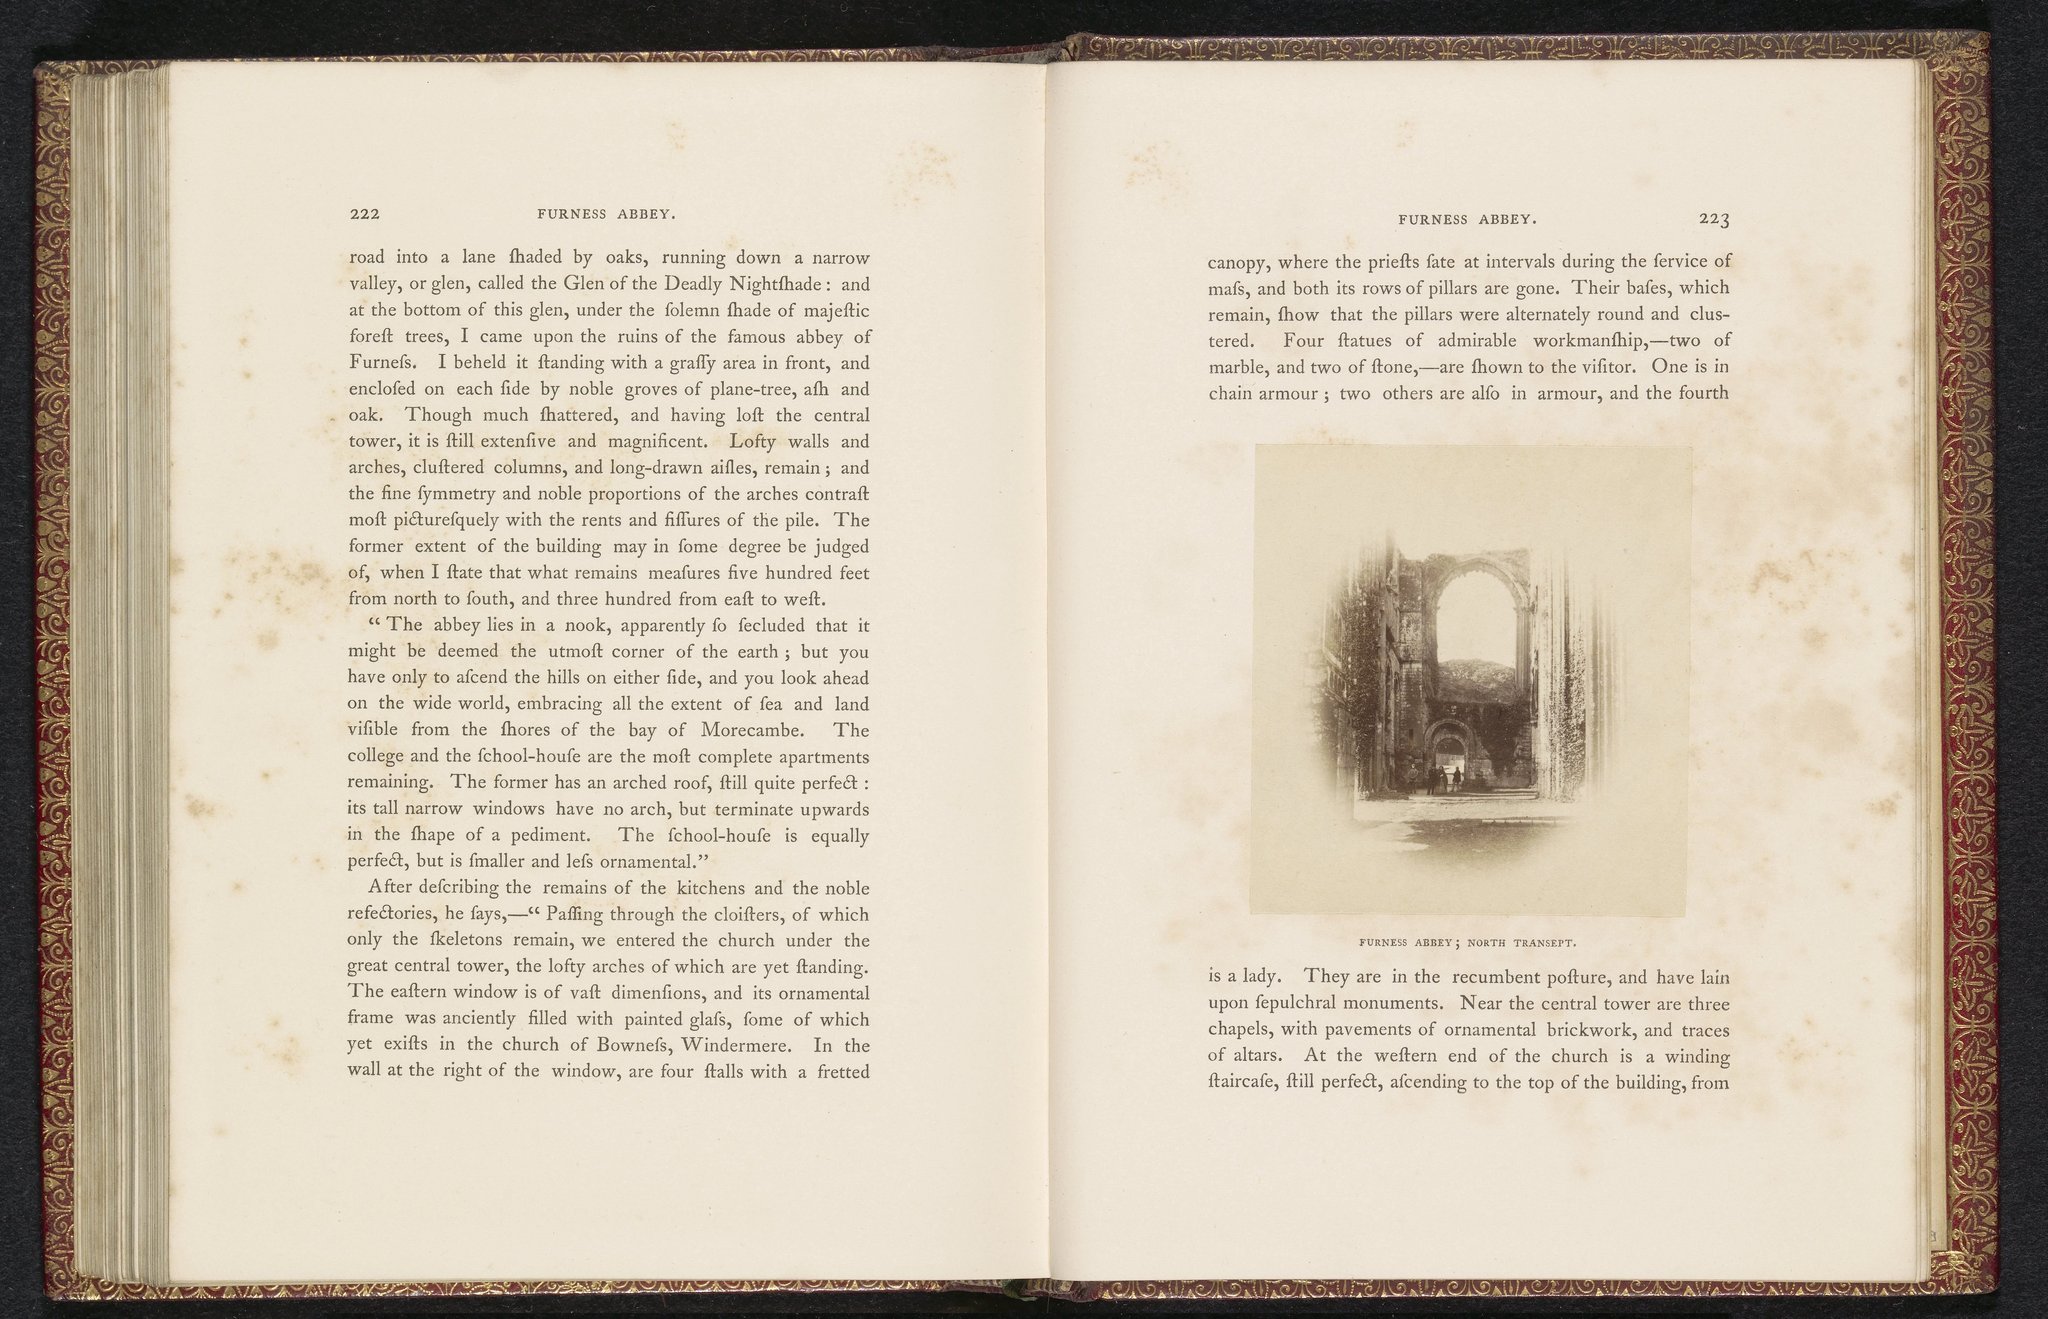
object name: page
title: Gezicht op de ruïne van de Abdij van Furness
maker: roger fenton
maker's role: fotograaf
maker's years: 1819-1869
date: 1852-1862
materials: photographic support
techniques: albumen print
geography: furness abbey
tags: gate, entrance, ruin of church, monastery, etc.